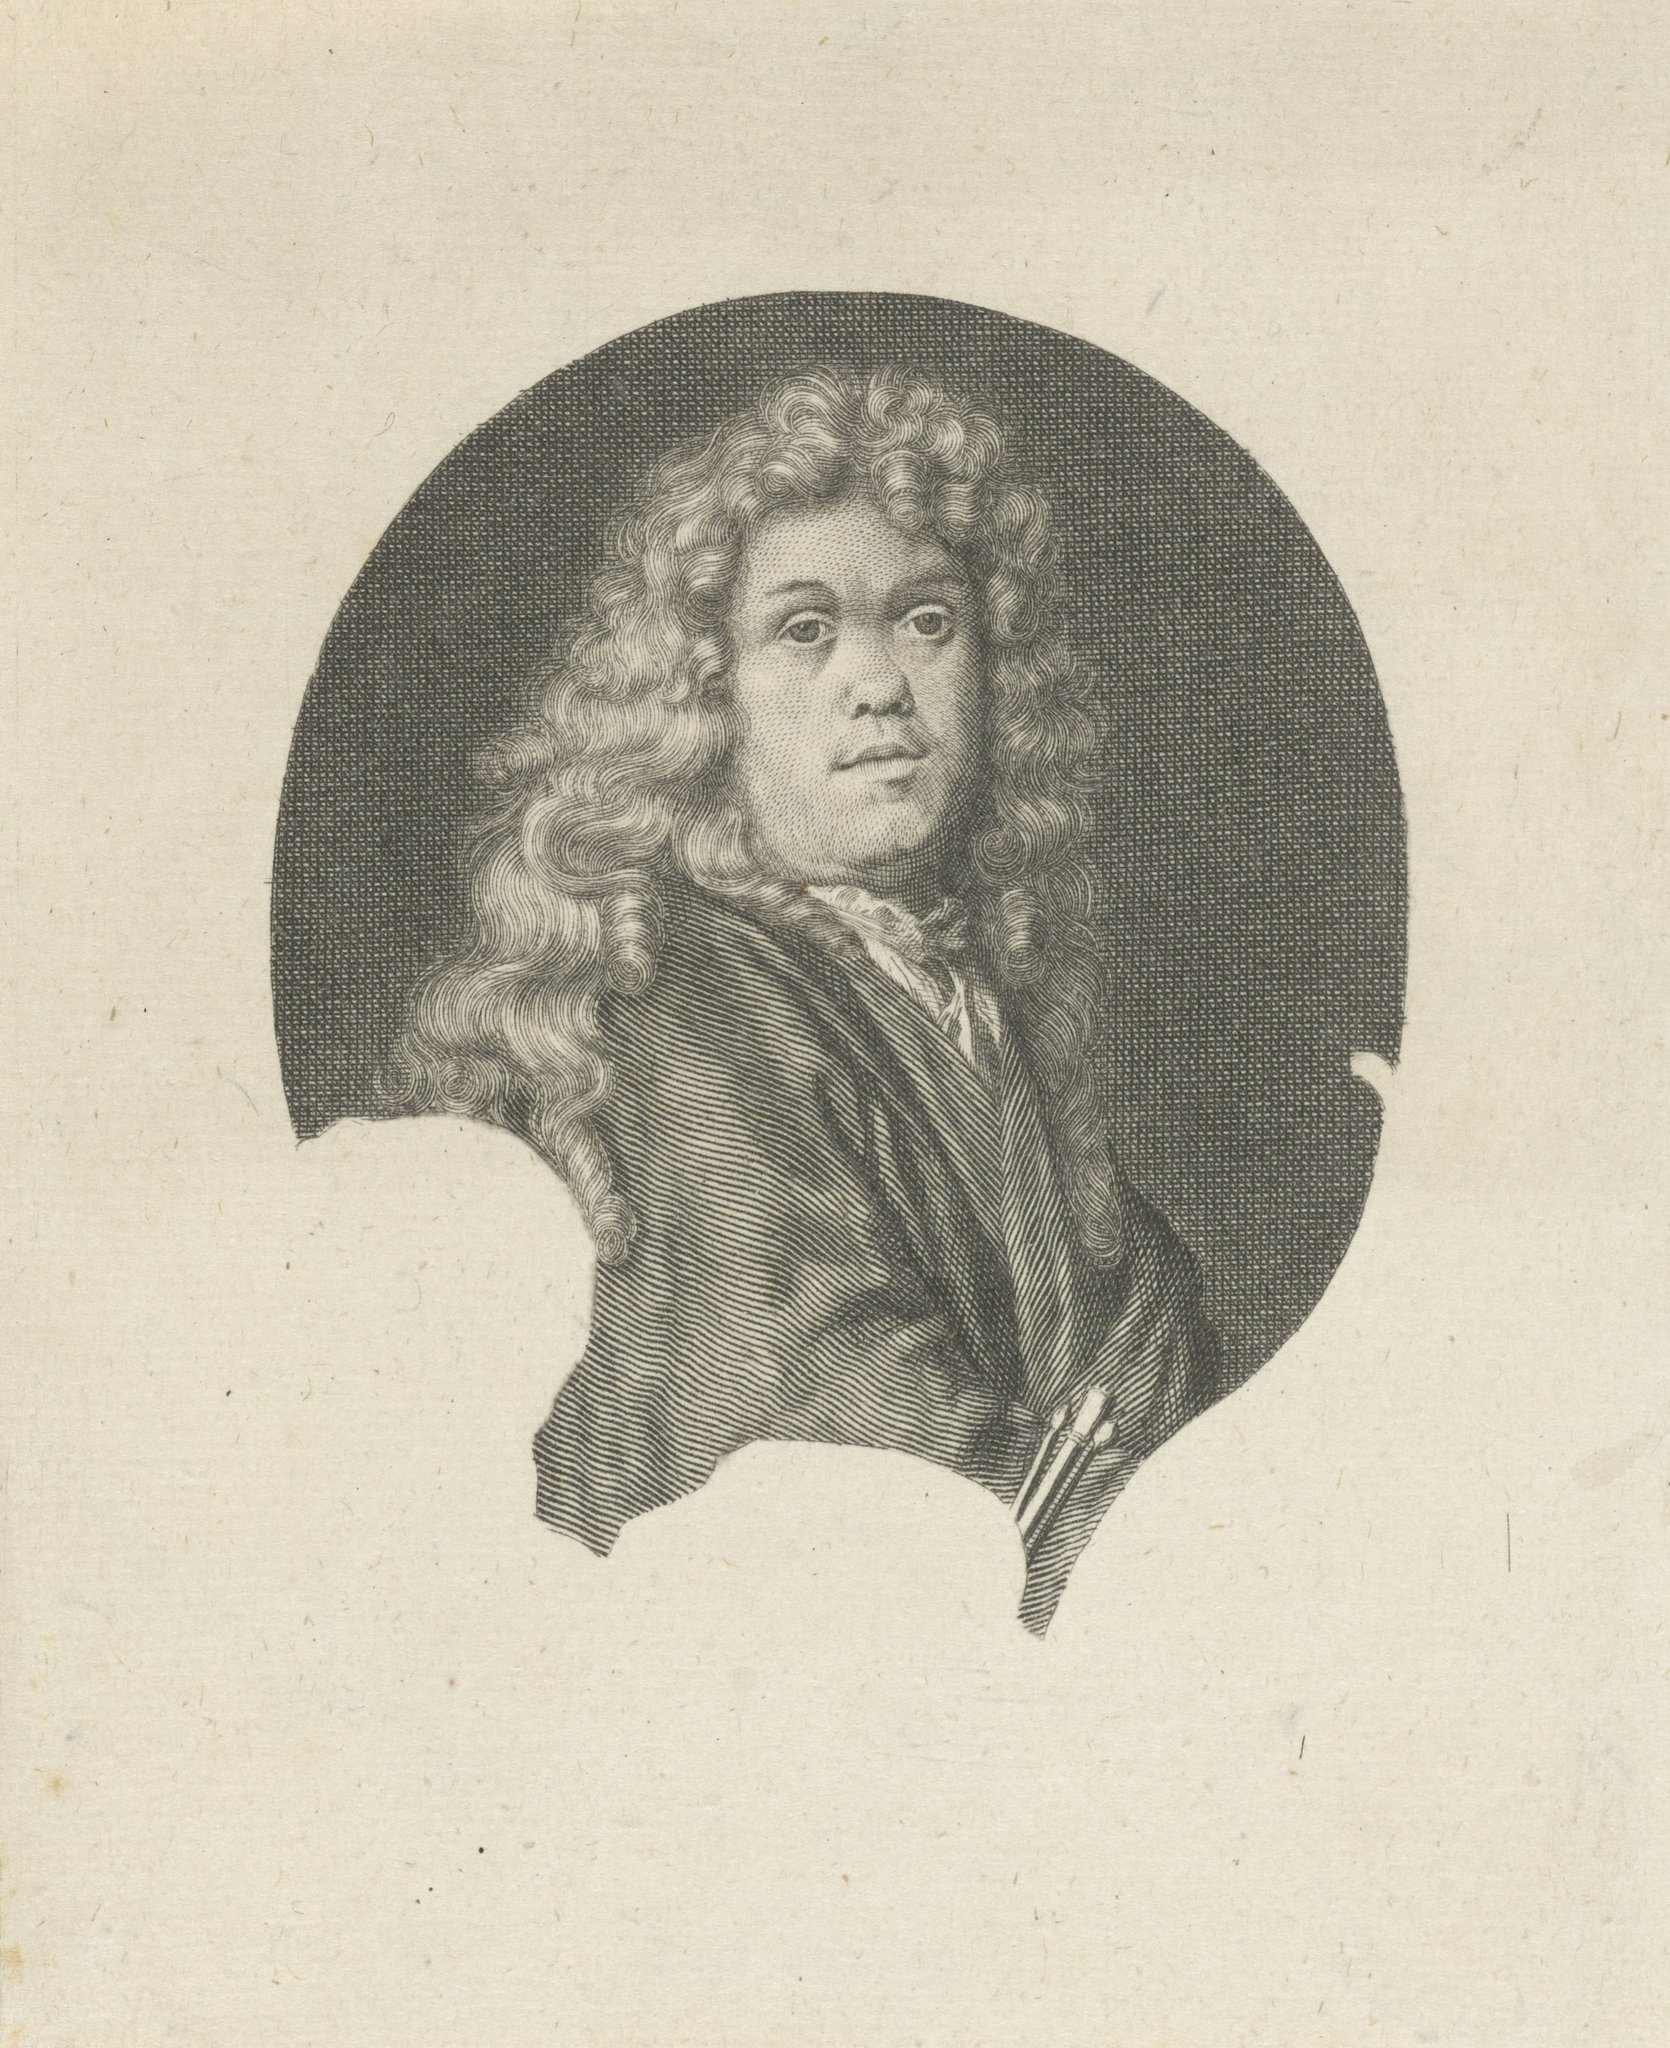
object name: print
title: Portret van Gerard De Lairesse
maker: pieter van gunst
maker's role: print maker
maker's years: 1658-1731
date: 1659-1731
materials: paper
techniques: engraving, etching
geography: amsterdam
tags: amsterdam, painter, print maker, draughtsman, gerard de lairesse, portrait, self-portrait of painter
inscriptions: collector's mark: Lugt 240, collector's mark: Lugt 2228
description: Gerard De Lairesse, een Luikse prentmaker en schilder. Het portret heeft de vorm van een schilderspalet.